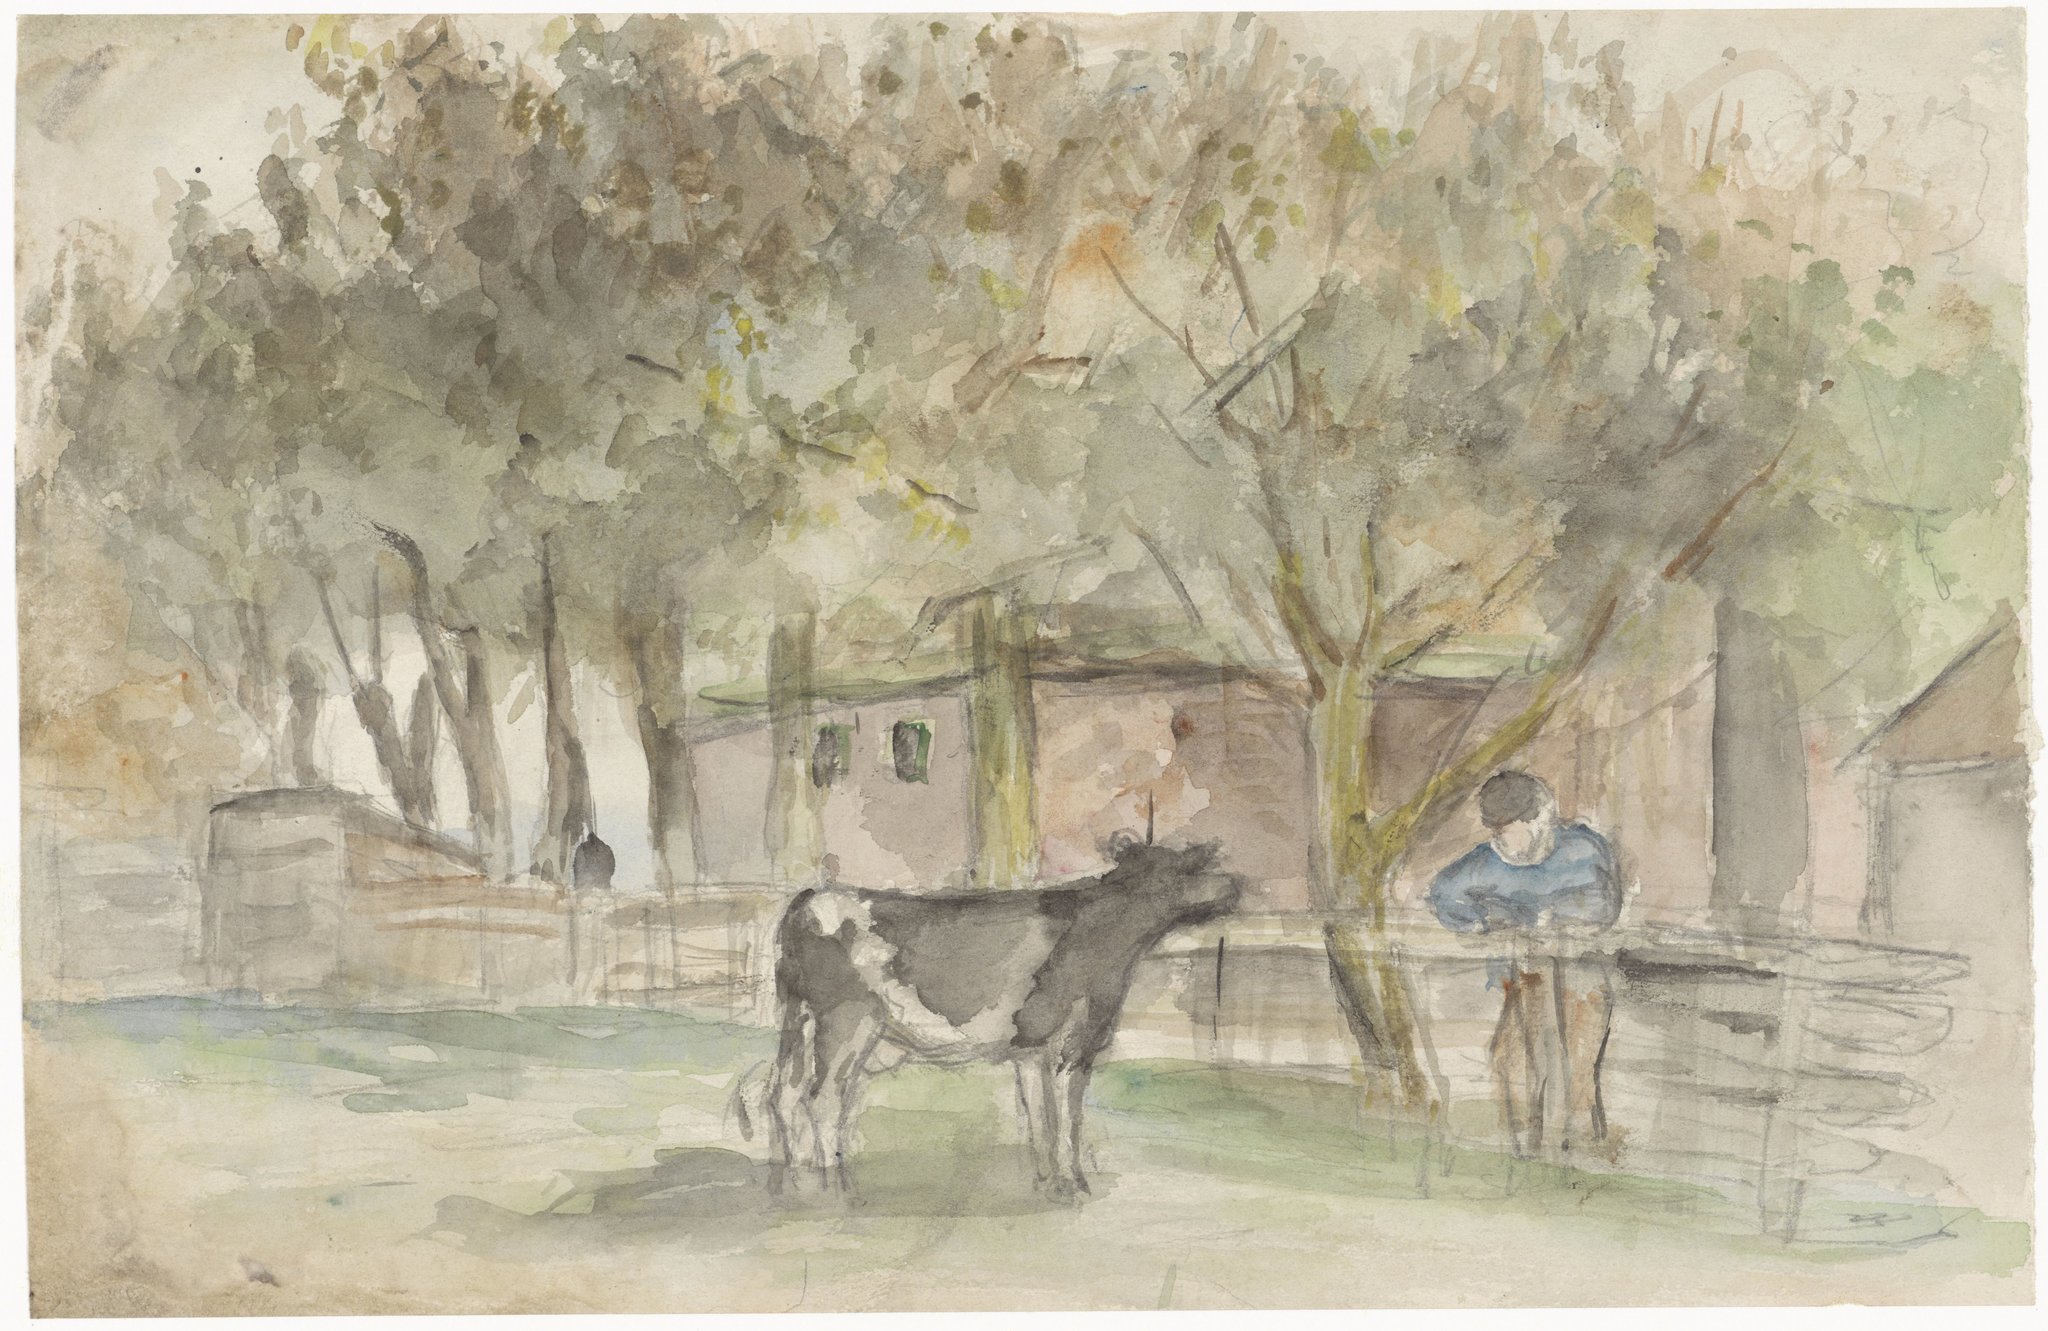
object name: watercolor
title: Landschap met een koe en een boer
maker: jozef israëls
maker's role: draughtsman, painter, print maker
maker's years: 1824-1911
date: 1834-1911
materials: paper, pencil, watercolor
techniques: brush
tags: cow, farm (building)